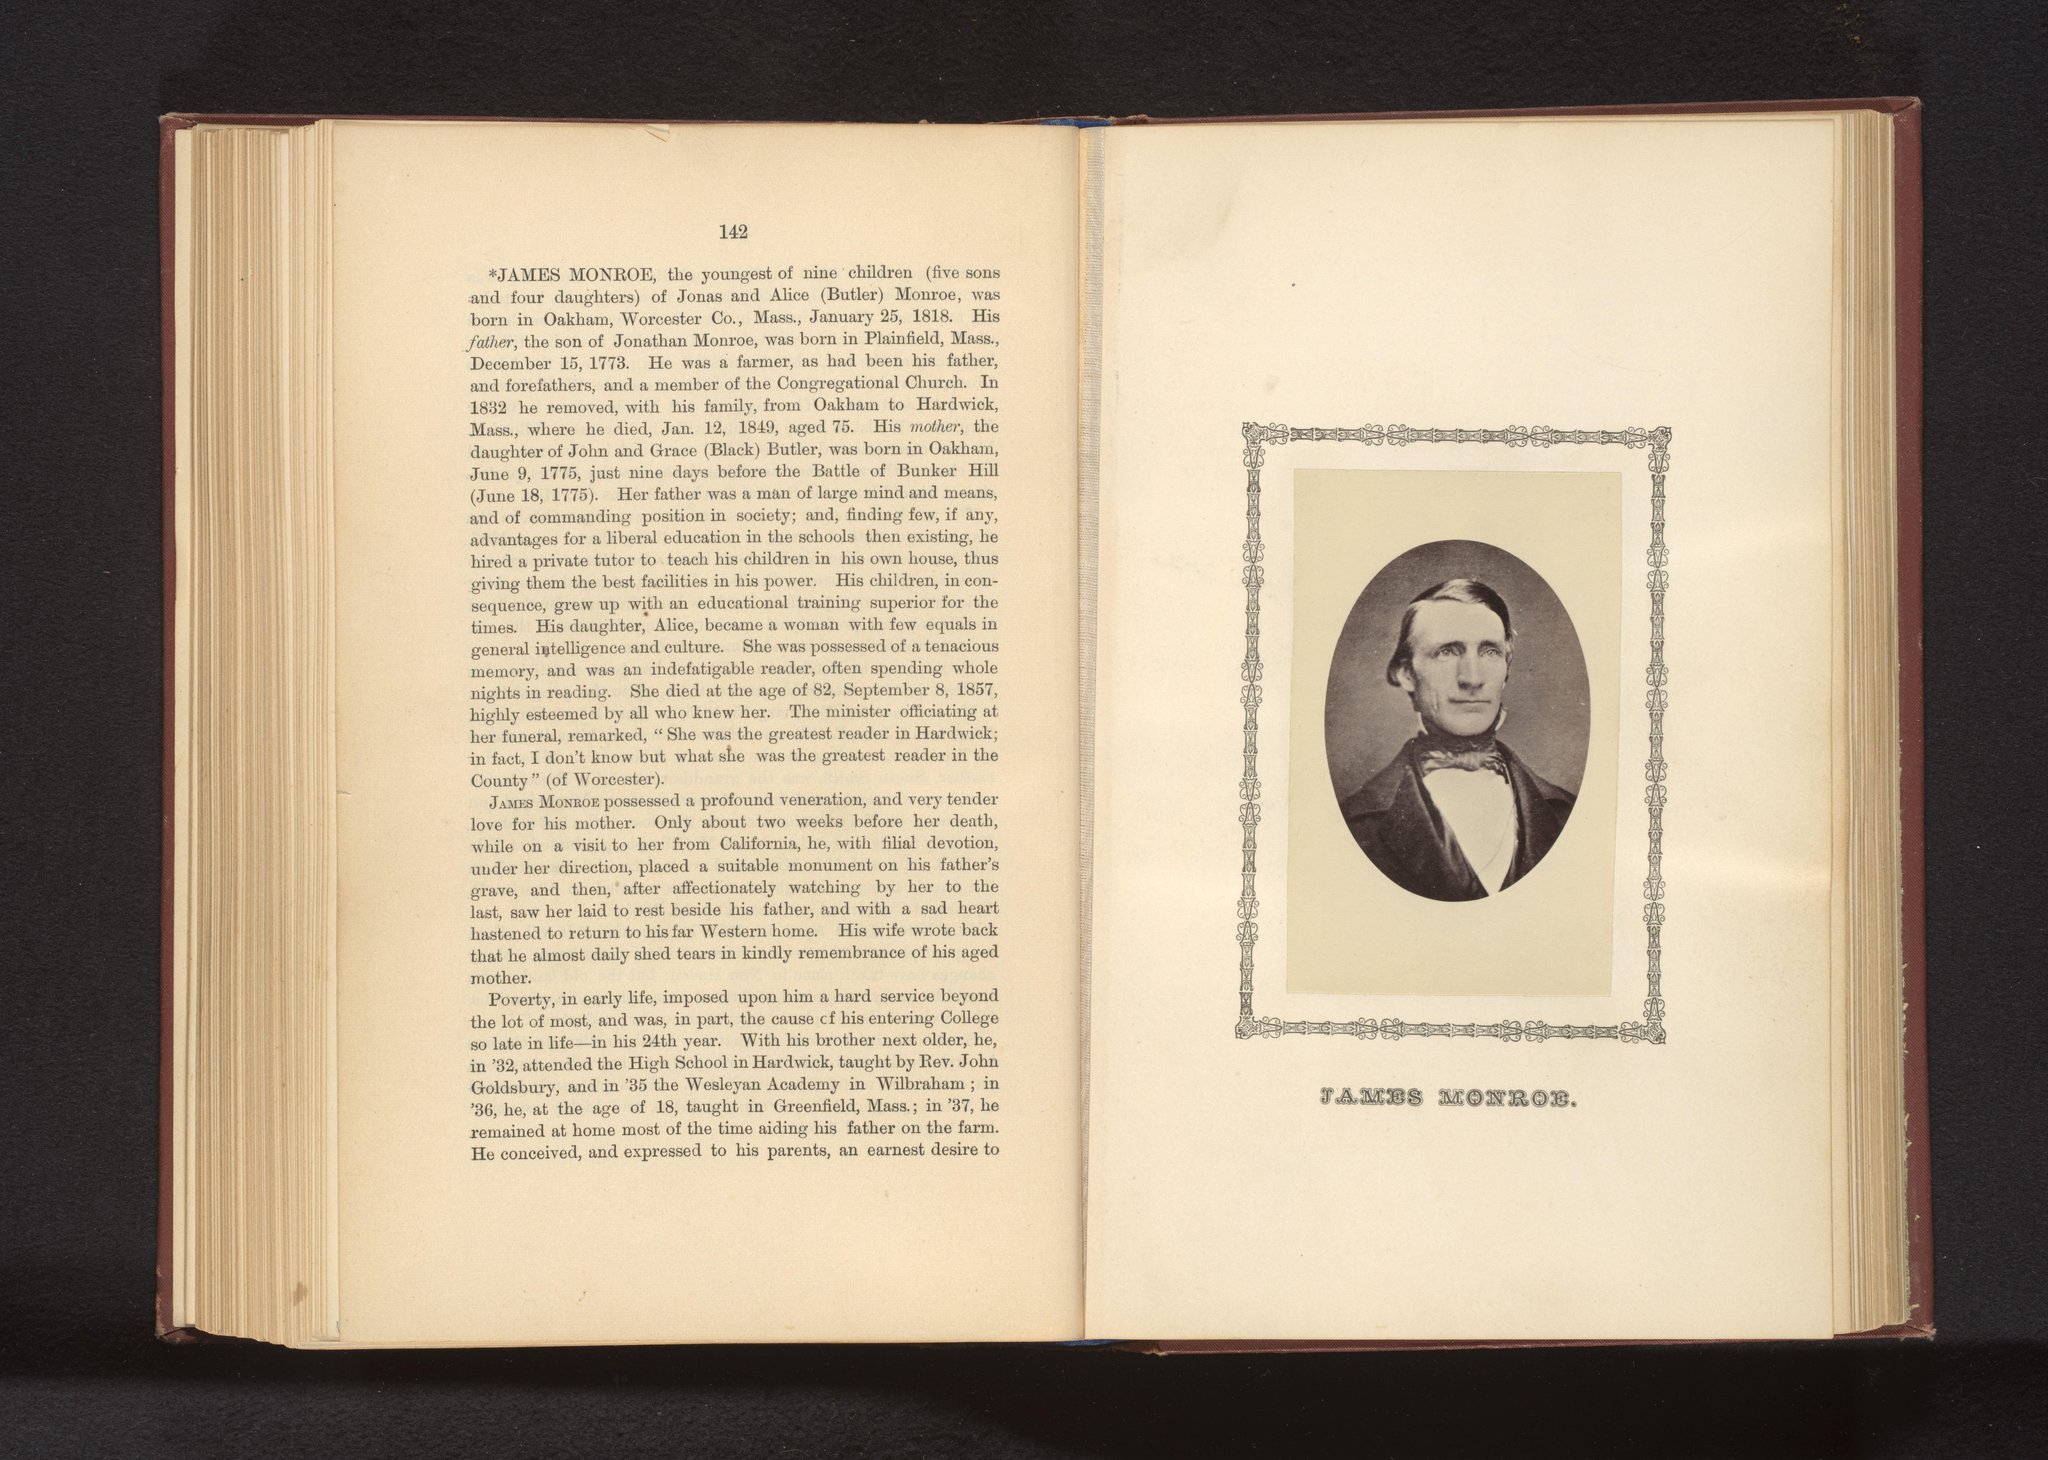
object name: page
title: James Monroe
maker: Anonymous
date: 1876-1881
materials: photographic support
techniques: albumen print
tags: adult man